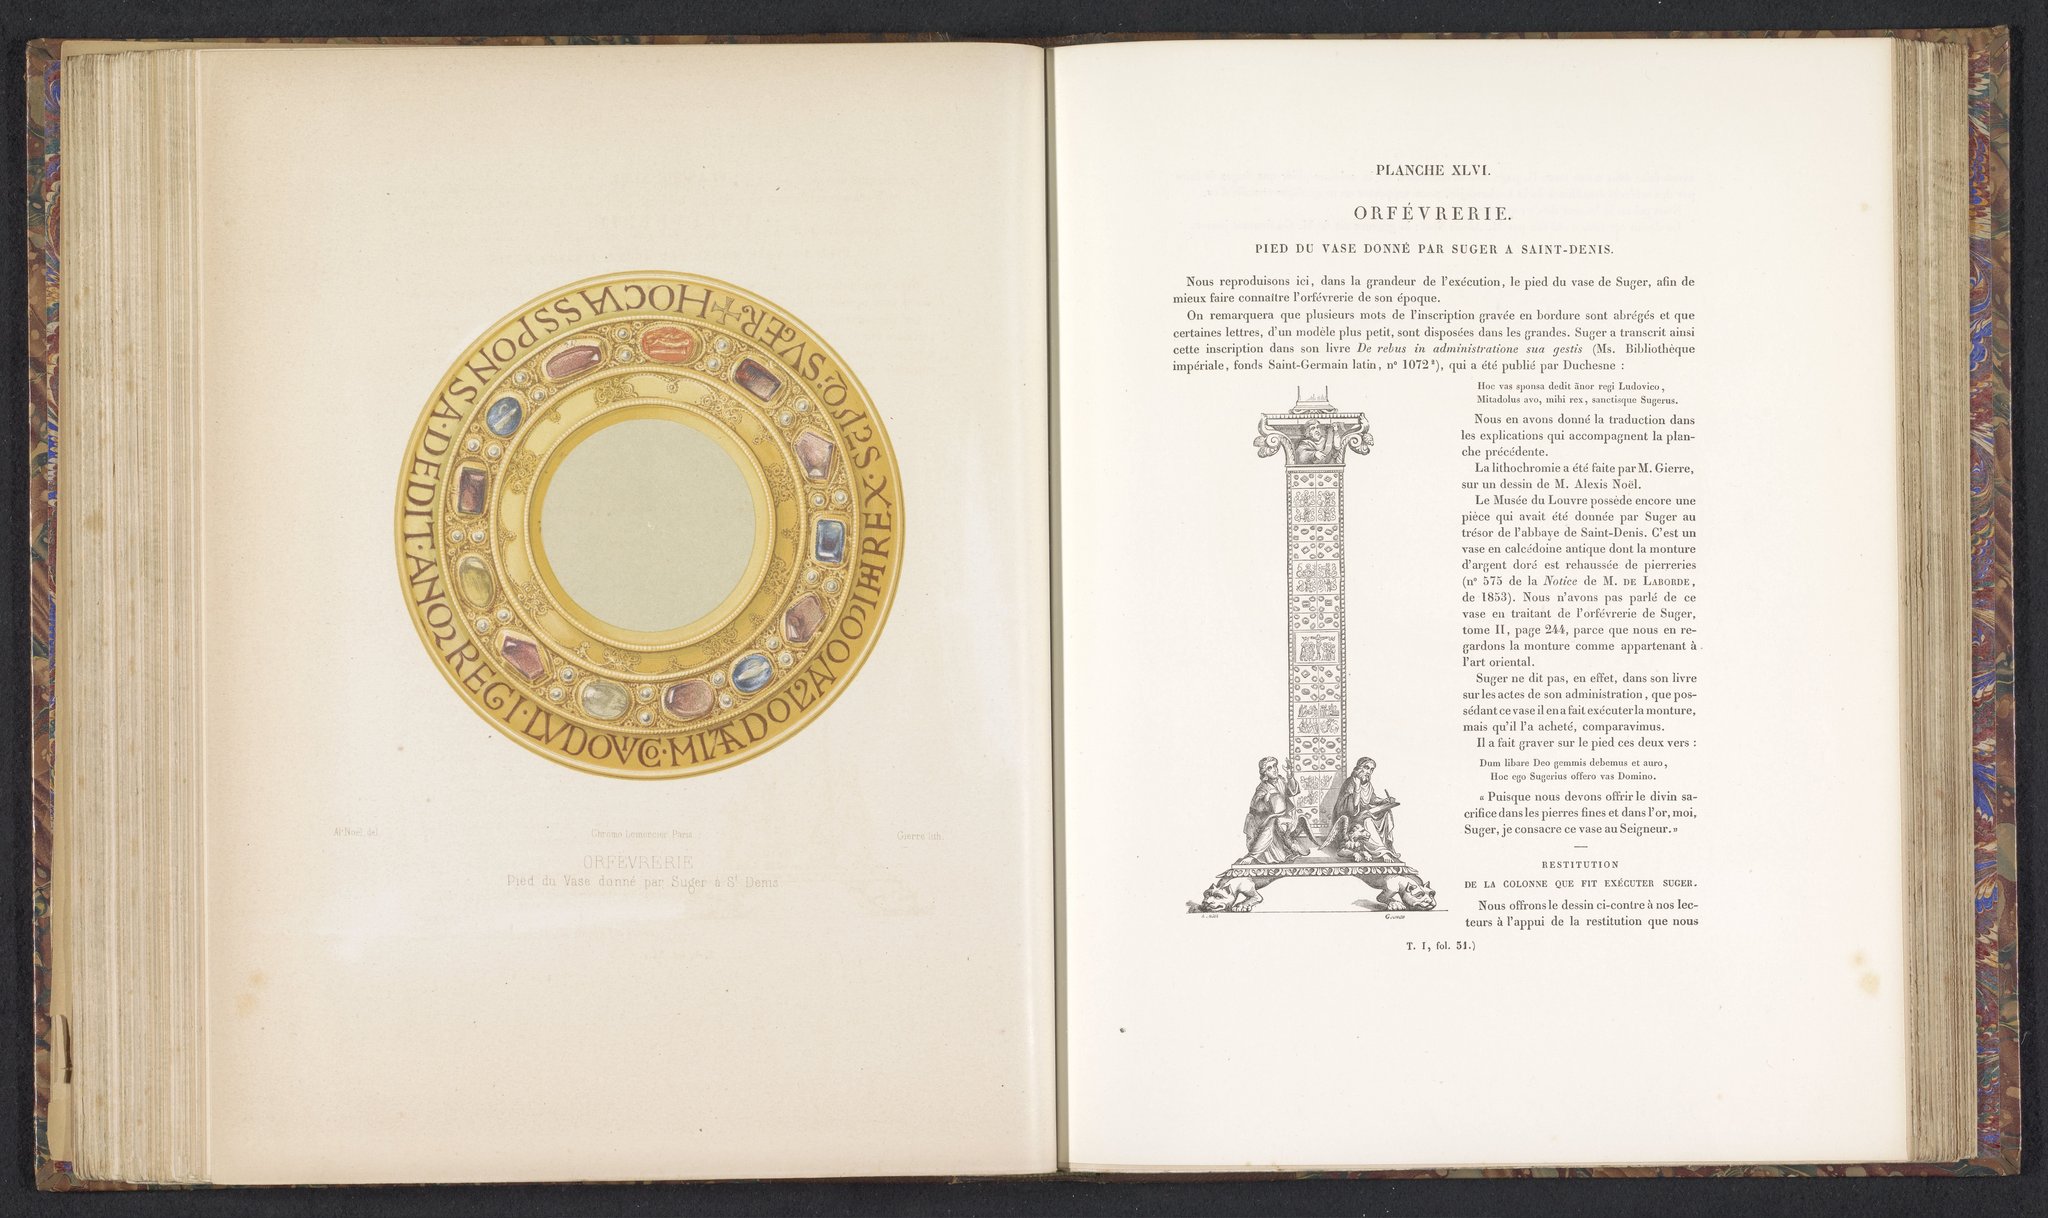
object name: print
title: Orfévrerie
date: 1859-1864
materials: paper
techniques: chromolithography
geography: paris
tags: container of (semi-)precious stone